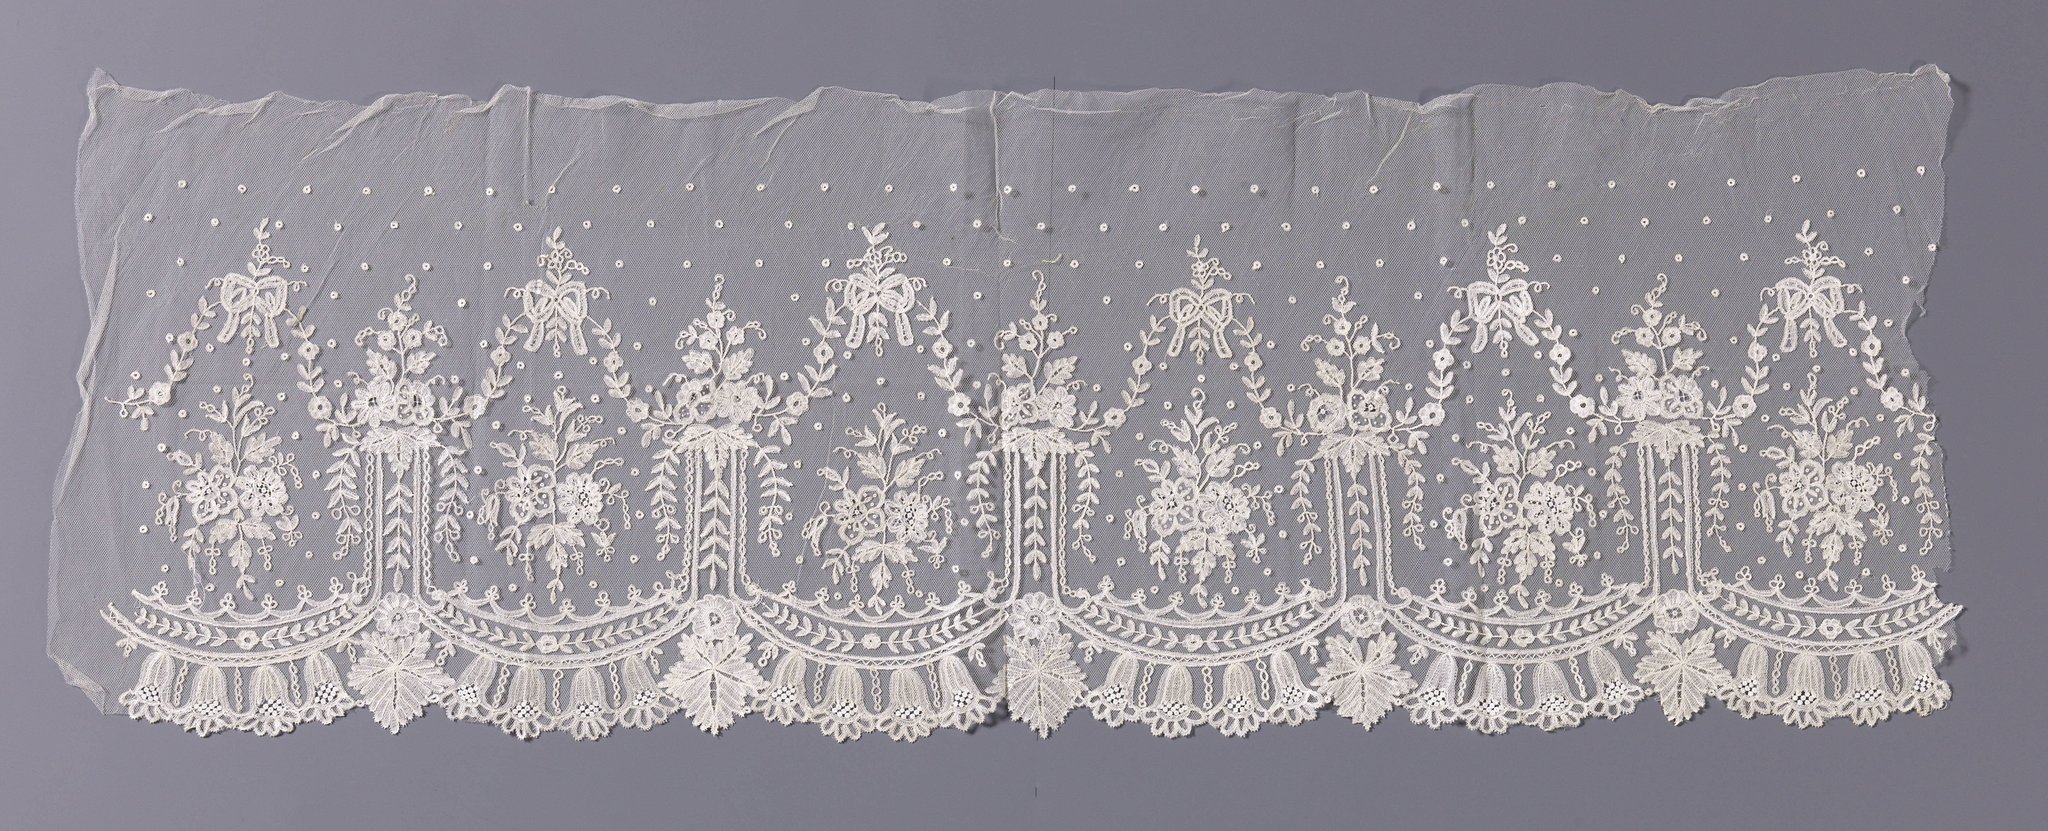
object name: japonstrook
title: Strook applicatiekant met u-vormige cartouches met strikken en bloemslingers erboven en klokjesbloemen eronder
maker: Anonymous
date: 1840-1860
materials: cotton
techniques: lace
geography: brussels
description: Japonstrook van naturelkleurige Brusselse applicatiekant: kloskant met naaldkantsiersteken - Brusselse duchesse - geappliceerd op machinale tule. Het zich herhalende patroon bestaat uit u-vormige cartouches met in elk een bloemtak. Boven elke cartouche een bloemslinger met een strik. Onder elk cartouche hangen vier klokjesbloemen tussen twee grote bladeren die elk worden bekroond door een rozetbloem. De machinale tulegrond is bezaaid met ringvormige moesjes. De motieven zijn gemaakt in linnenslag met opengewerkte randjes. De motieven zijn grotendeels voorzien van contourdraden en op verschillende plekken zijn gekloste reliëfcontouren toegepast. In de grootste bloemen zijn naaldkantsiersteken toegepast, al dan niet geappliceerd op ingezette stukjes fijnere tule. De bovenzijde van de strook is afgeknipt en niet afgewerkt. De schulpenrand komt voort uit het patroon met de u-vormige cartouches, waarbij de klokjesbloemen tussen de bladeren de lobben aan de schulpen vormen. De lobben zijn afgewerkt met picots.